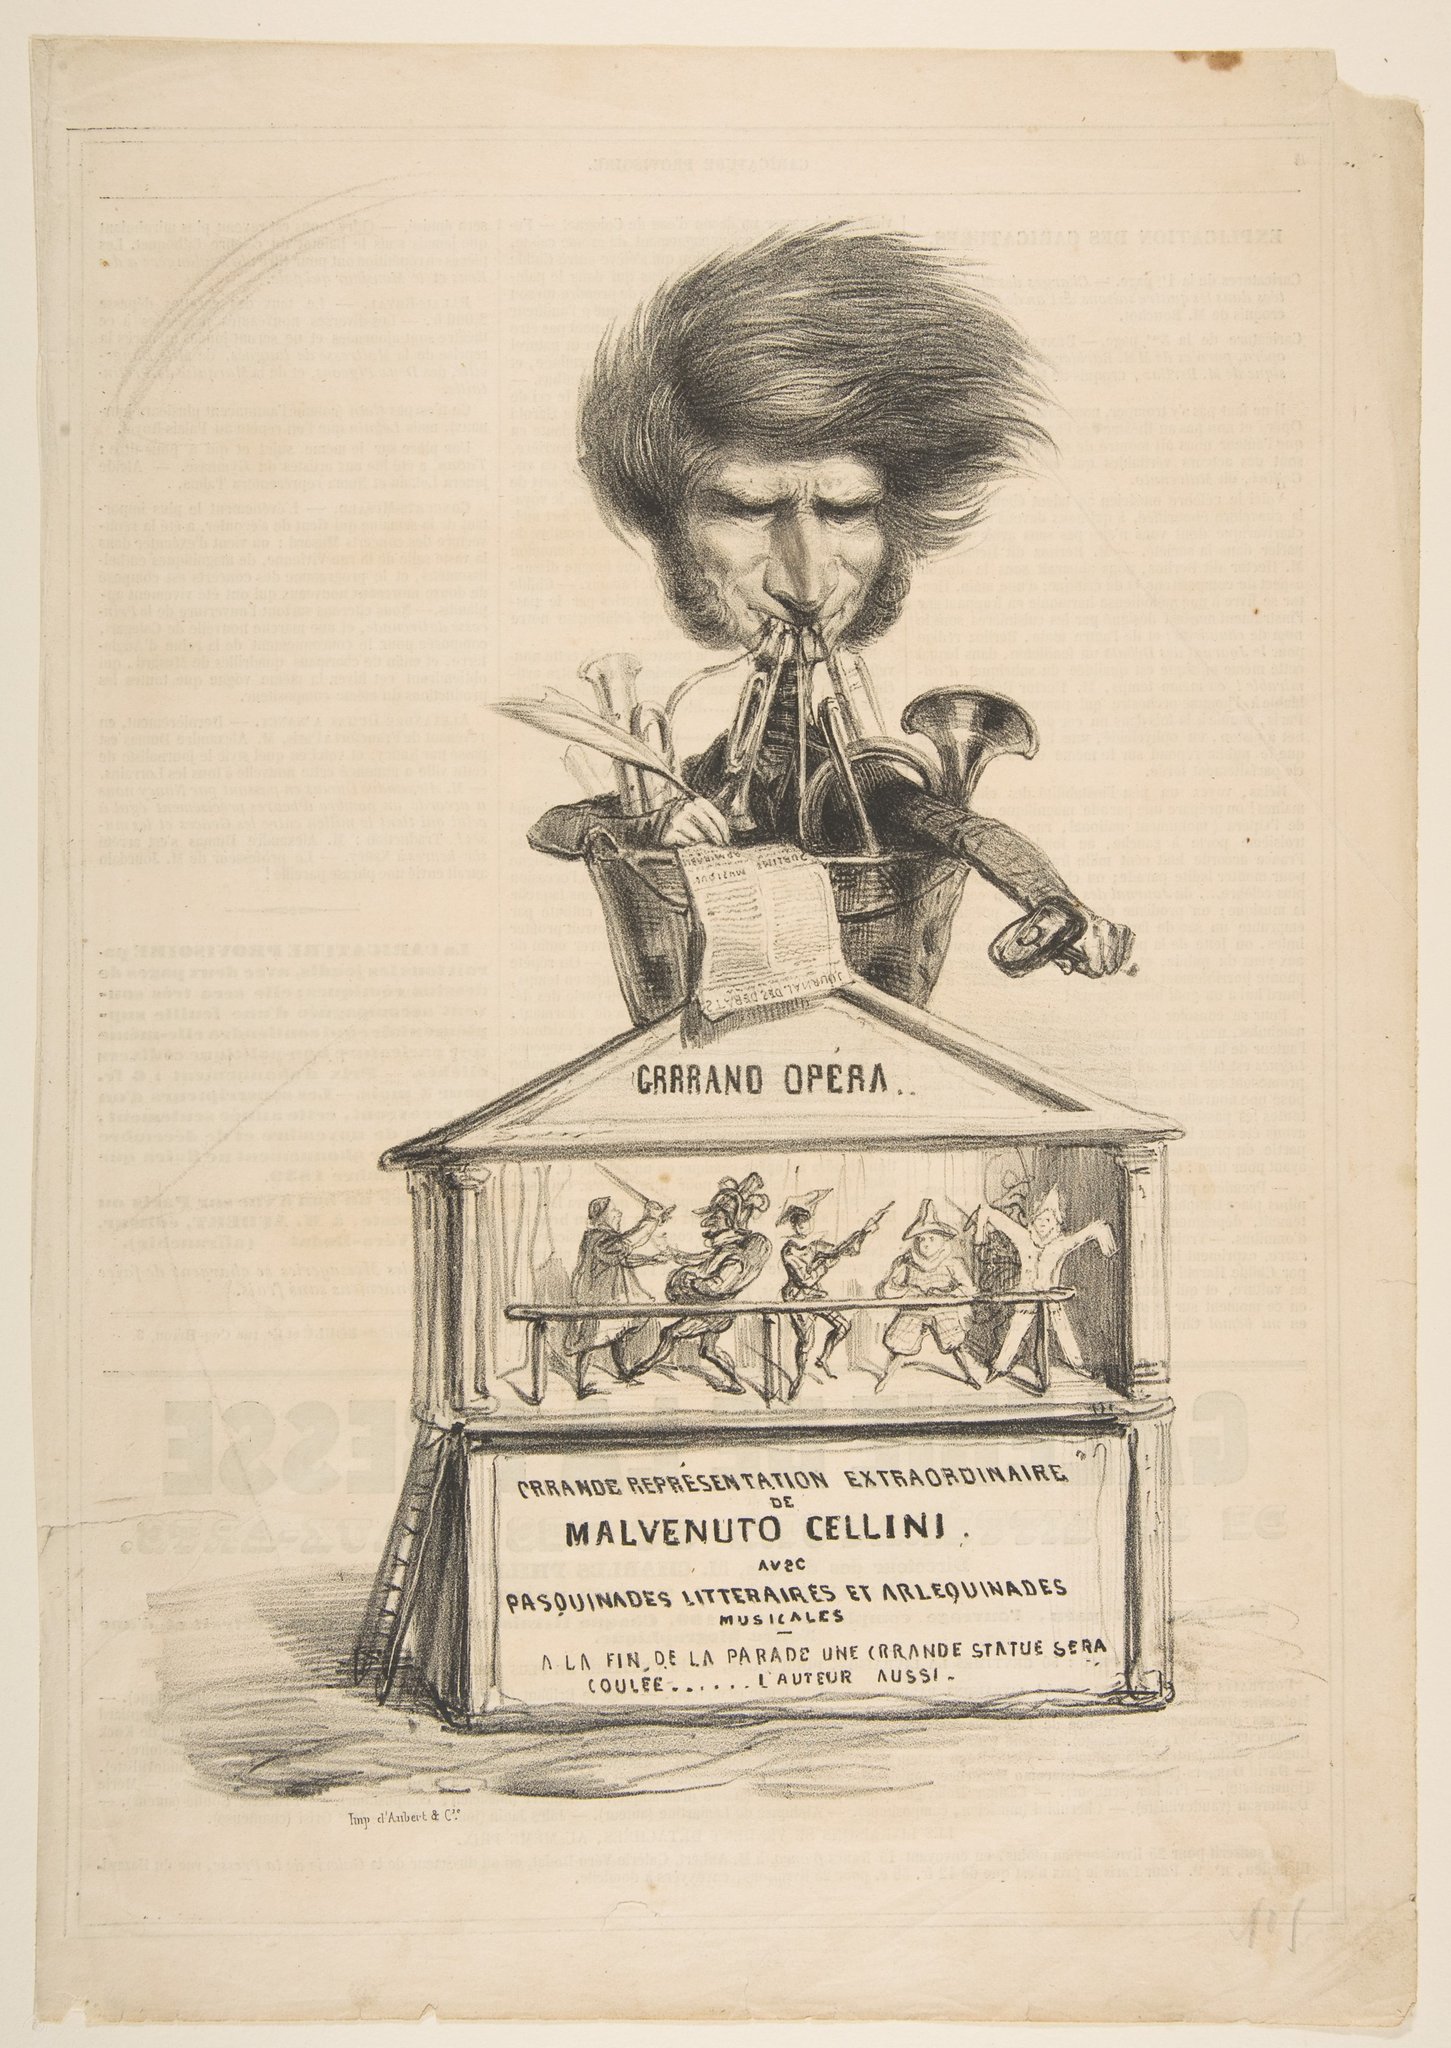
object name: print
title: Caricature of Berlioz, from "La Caricature Provisoire, no. 1"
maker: benjamin roubaud (called "benjamin")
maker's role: artist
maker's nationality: french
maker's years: 1811-1847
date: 1838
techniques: lithograph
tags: musical instruments,men,writing,caricature